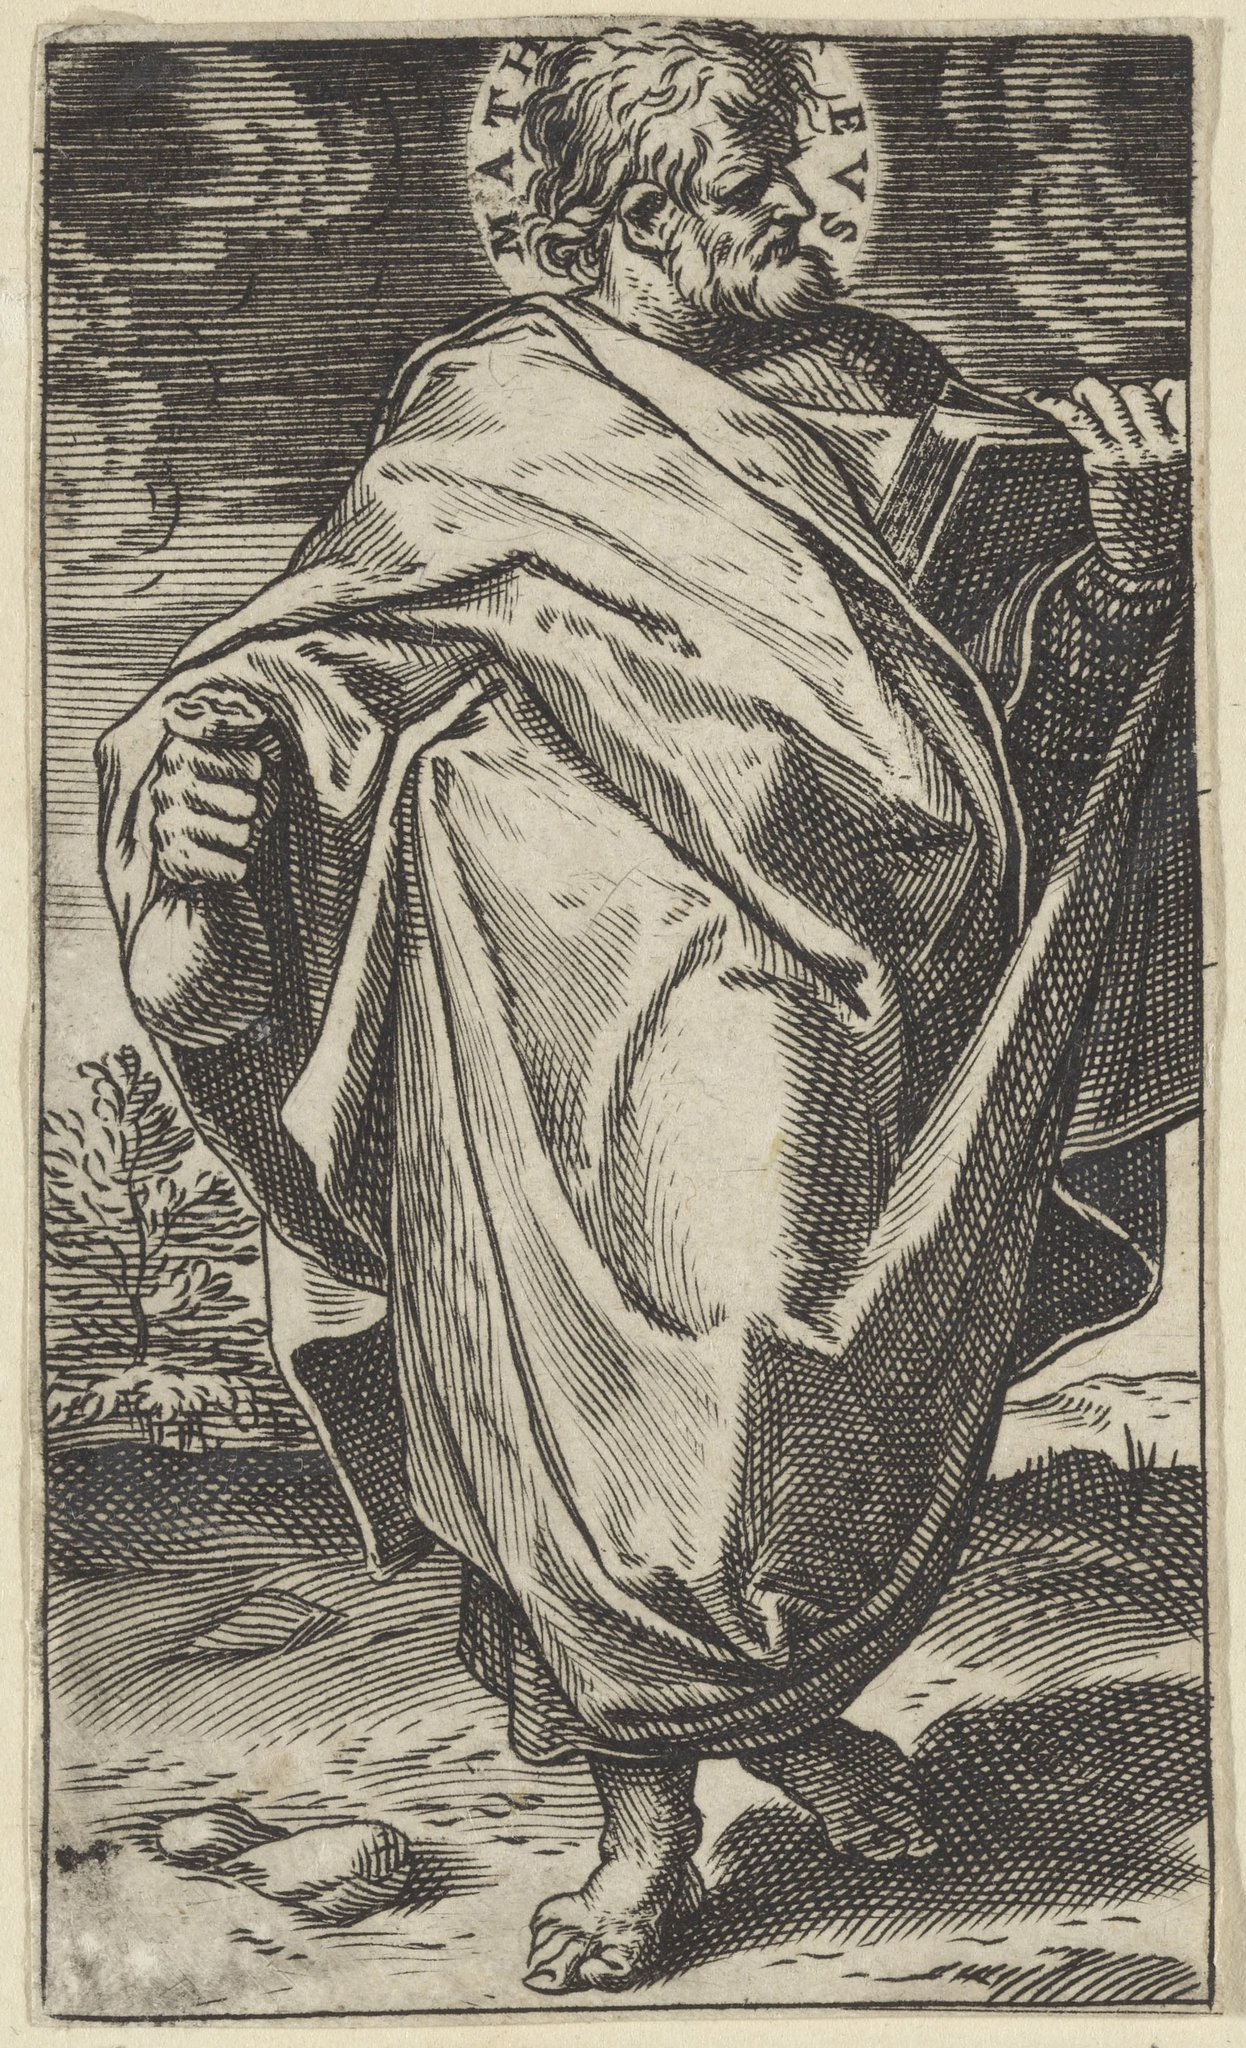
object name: print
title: Christus, Maria, Johannes de Doper en de apostelen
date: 1583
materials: paper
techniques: engraving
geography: venice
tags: the apostle and evangelist matthew (mattheus); possible attributes: angel, axe, book, halberd, pen and inkhorn, purse, scroll, square, sword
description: Afbeelding gesneden uit een blad met drie voorstellingen van de apostelen Matteüs met een boek, Andreas met een kruis en Johannes met een kelk.